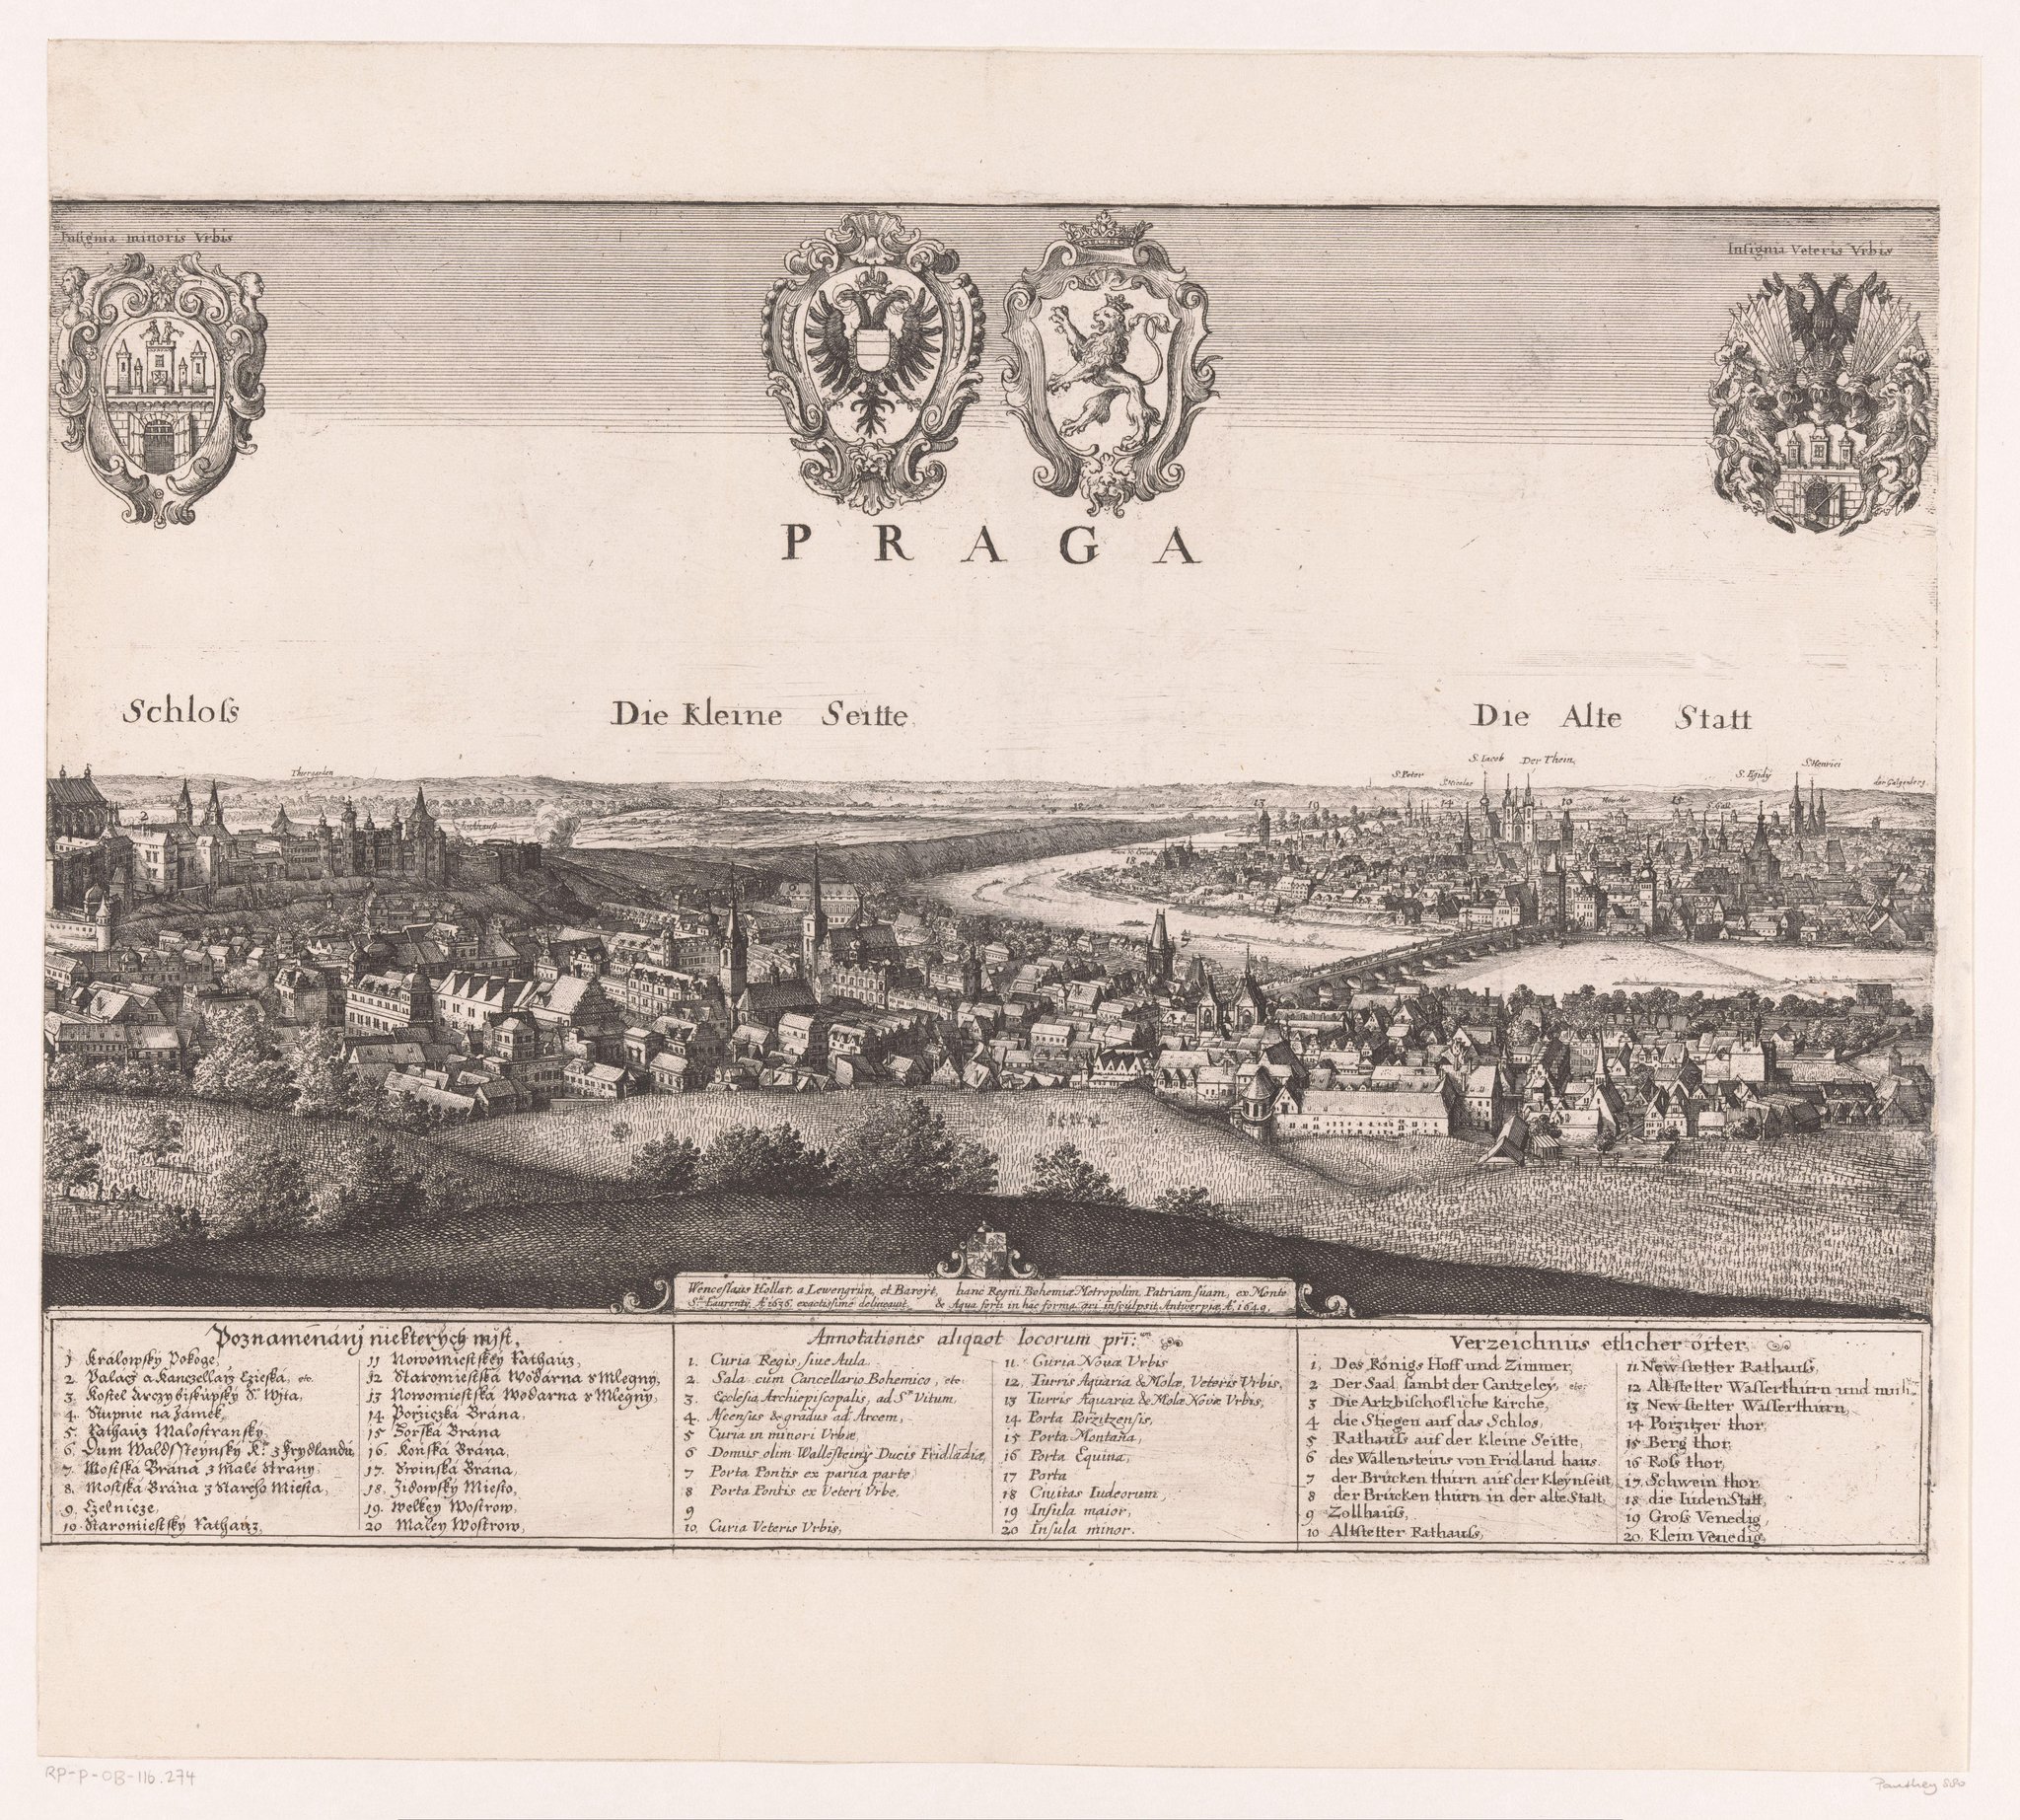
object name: print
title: Gezicht op Praag (middelste deel)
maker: wenceslaus hollar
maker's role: draughtsman, print maker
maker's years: 1607-1677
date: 1649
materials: paper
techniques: etching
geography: germany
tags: maps of cities, coat of arms (as symbol of the state, etc.) (+ province; provincial), prospect of city, town panorama, silhouette of city, prague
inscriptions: collector's mark: Lugt 2228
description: Middelste deel van een gezicht op de stad Praag, bestaande uit drie delen. Onderaan kaders met de legenda in het Tsjechisch, Latijn en Duits.